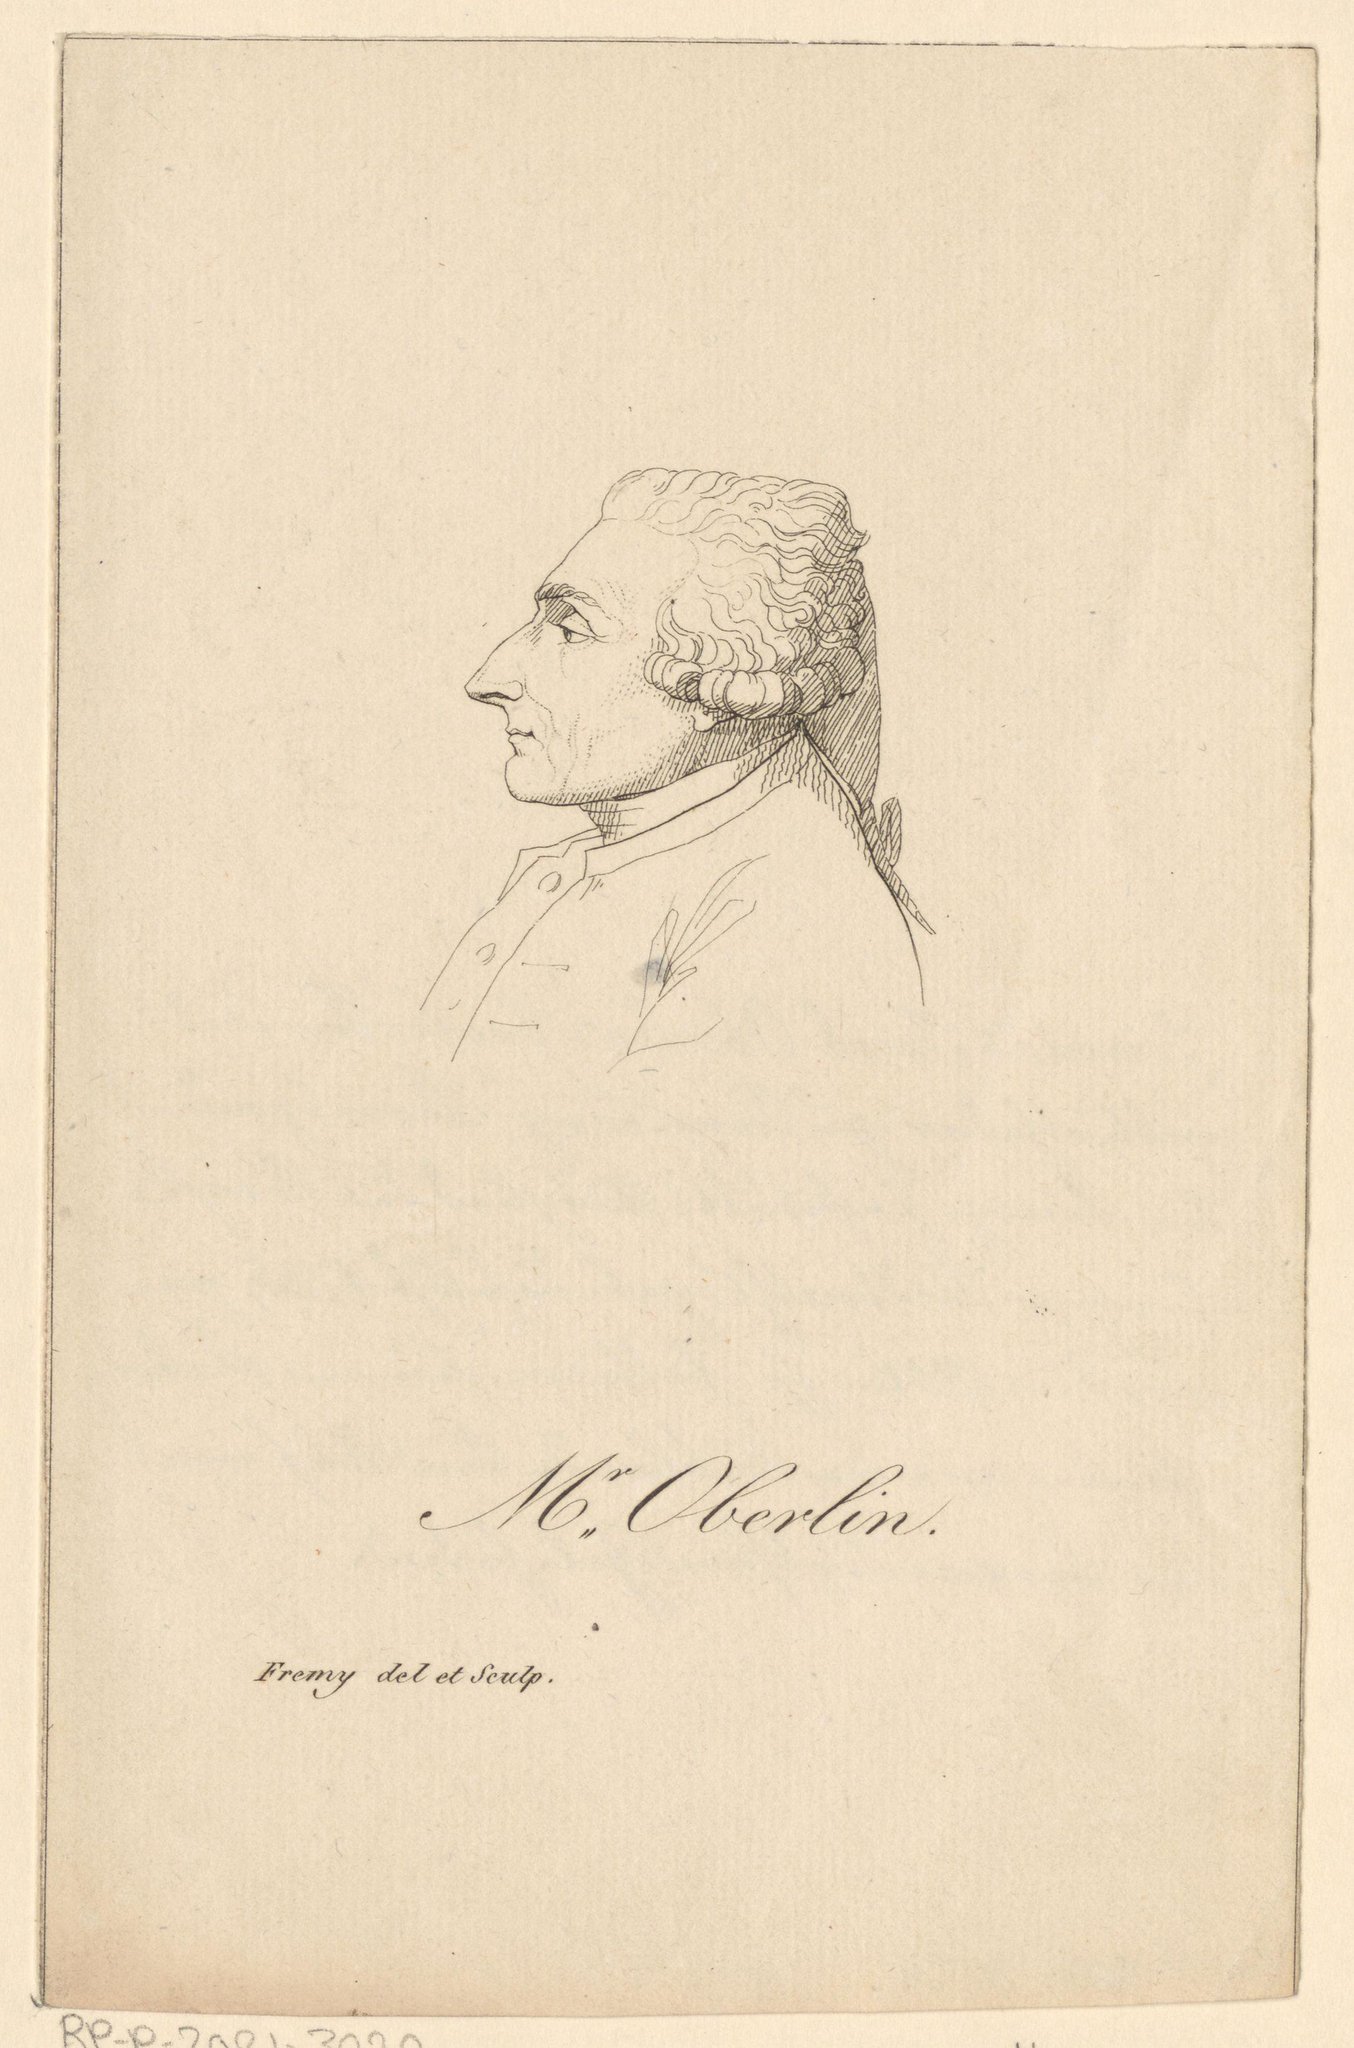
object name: print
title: Portret van Jeremias Jacob Oberlin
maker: jacques noël marie frémy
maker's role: print maker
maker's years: 1782-1867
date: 1815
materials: paper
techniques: etching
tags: historical persons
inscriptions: annotation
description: Prent mogelijk uit: Frémy, Jacques Noël Marie. Croquis de portraits des personnages remarquables (...). Parijs: Jacques Noël Marie Frémy, 1815, dl. 1.